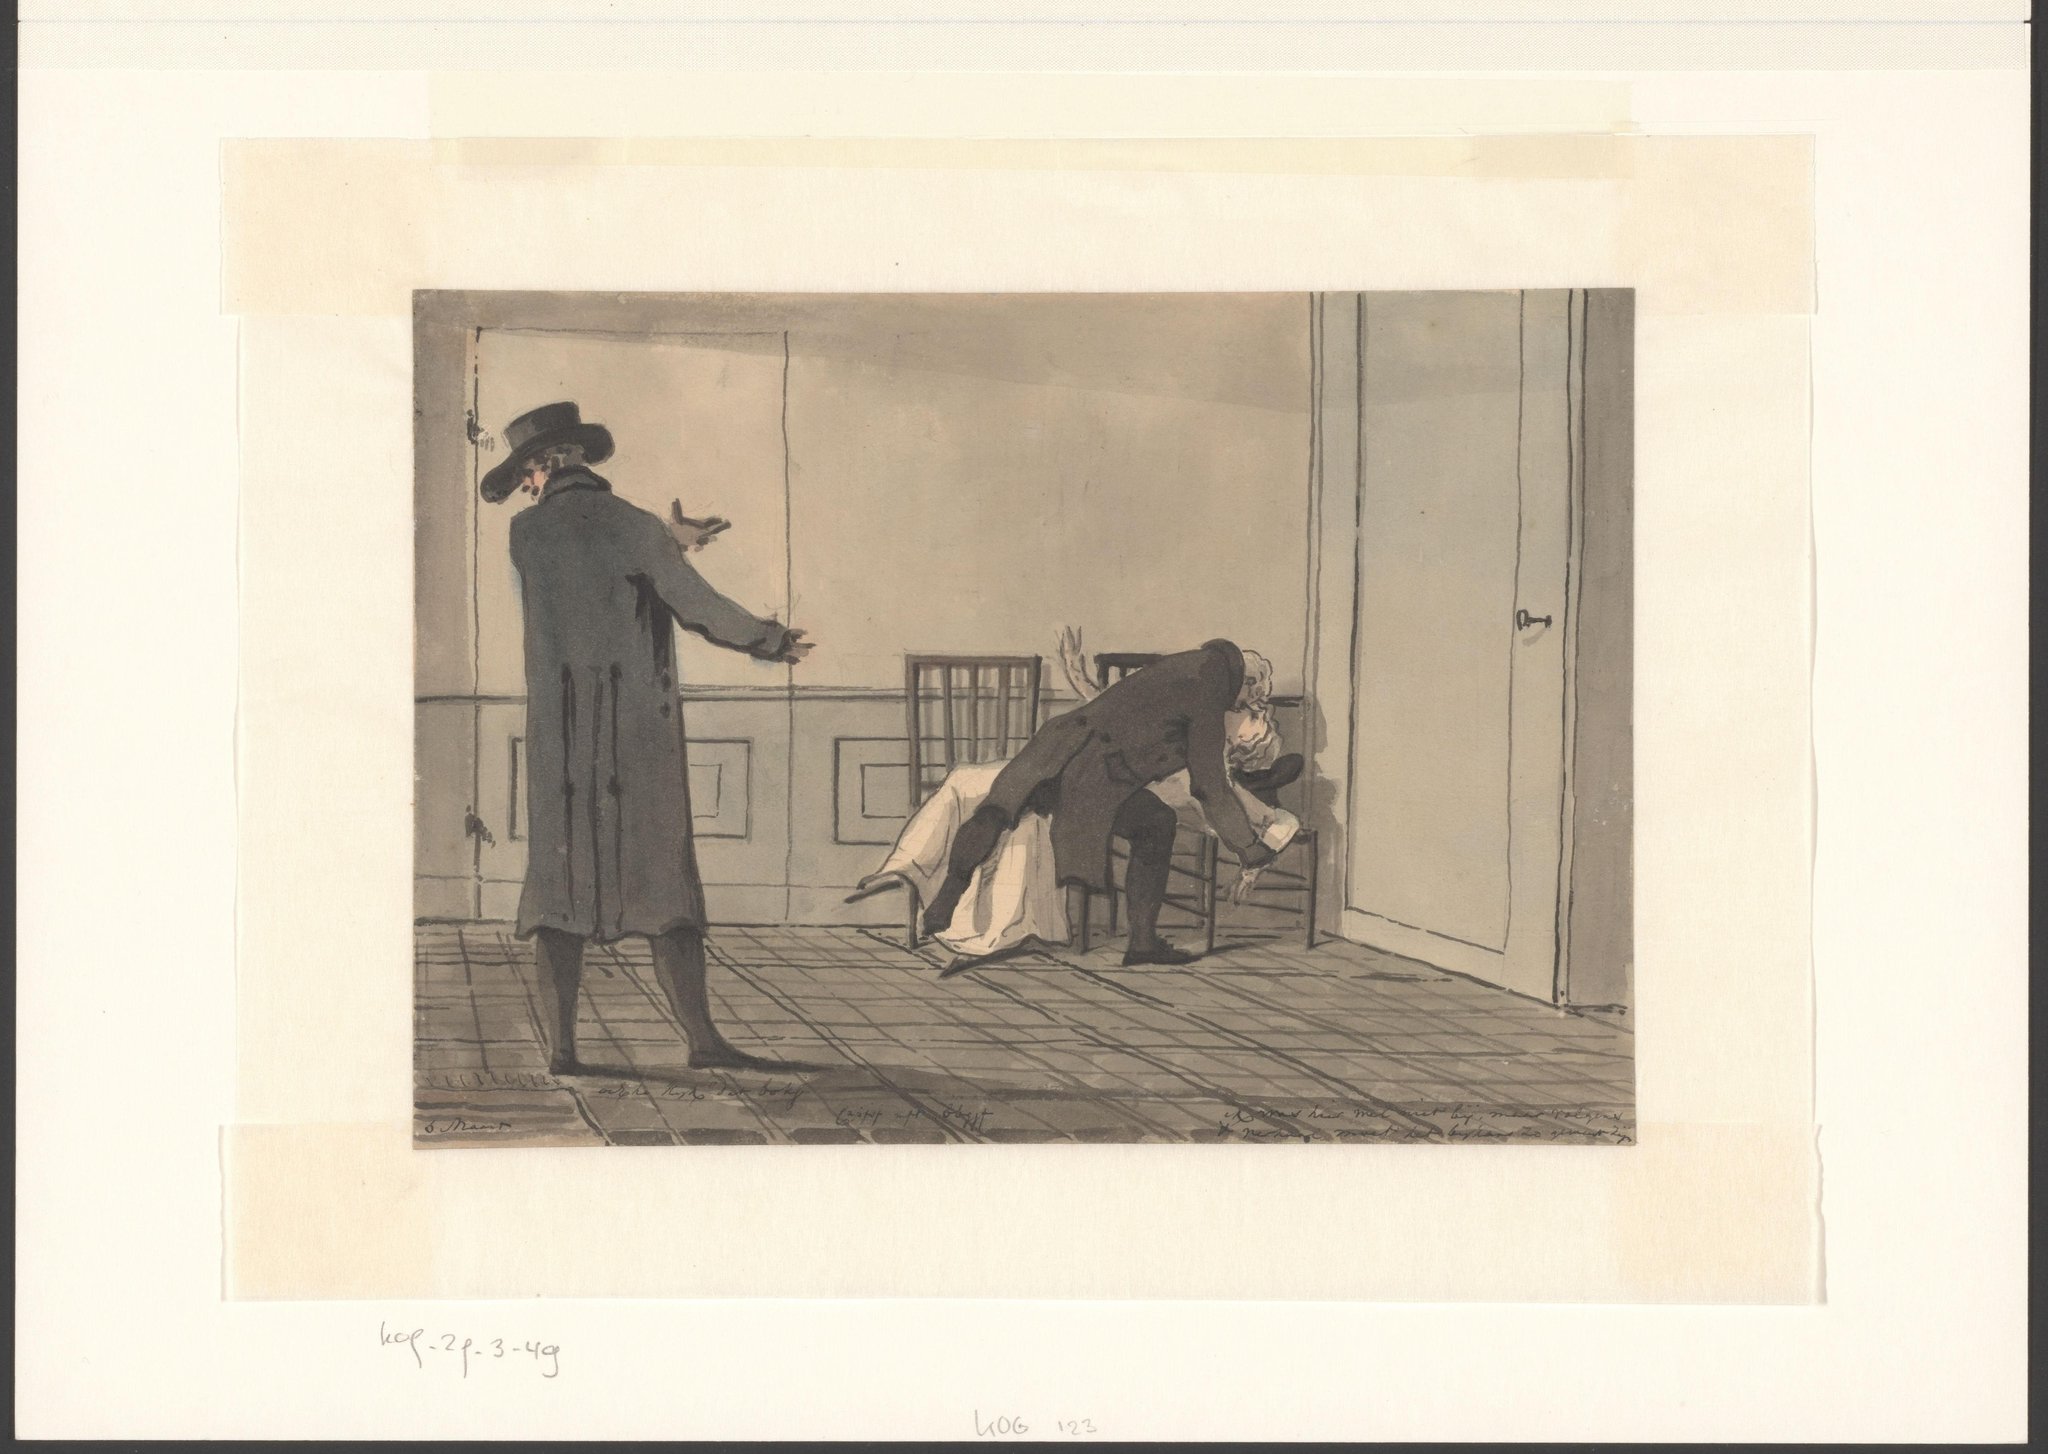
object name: drawing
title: Christiaan Andriessen wijst naar een zoenend koppel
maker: christiaan andriessen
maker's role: draughtsman, print maker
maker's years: 1775-1846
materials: ink, paper, pencil, watercolor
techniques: brush, pen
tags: amsterdam, print maker, christiaan andriessen, (lovers) kissing each other, embracing each other, kissing, head-gear: top hat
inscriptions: inscription: ‘J Andriessen’, inscription: ‘29 julij dat gaat wederom naar Weesp’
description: Dagboekblad uit het getekende dagboek dat Christiaan Andriessen bijhield van 1805 tot en met 1808.